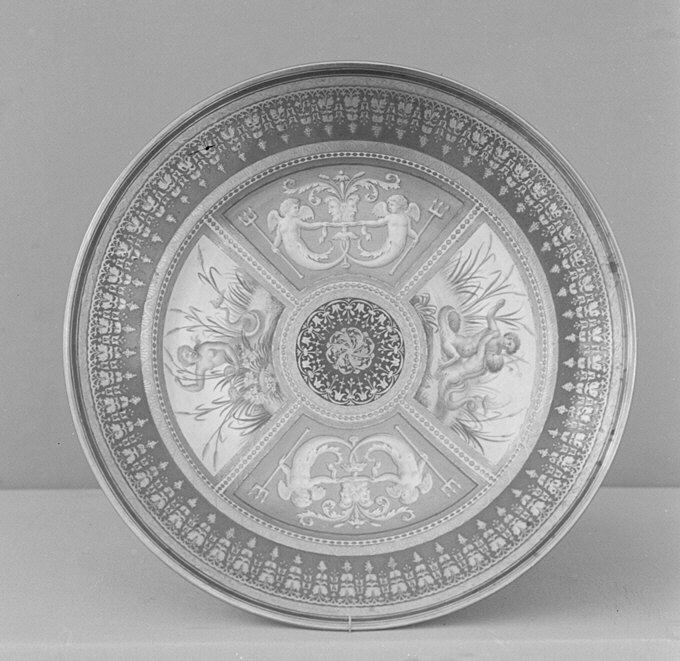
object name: plate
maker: imperial porcelain manufactory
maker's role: manufactory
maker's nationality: austrian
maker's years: 1744-1864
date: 1794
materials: hard paste porcelain